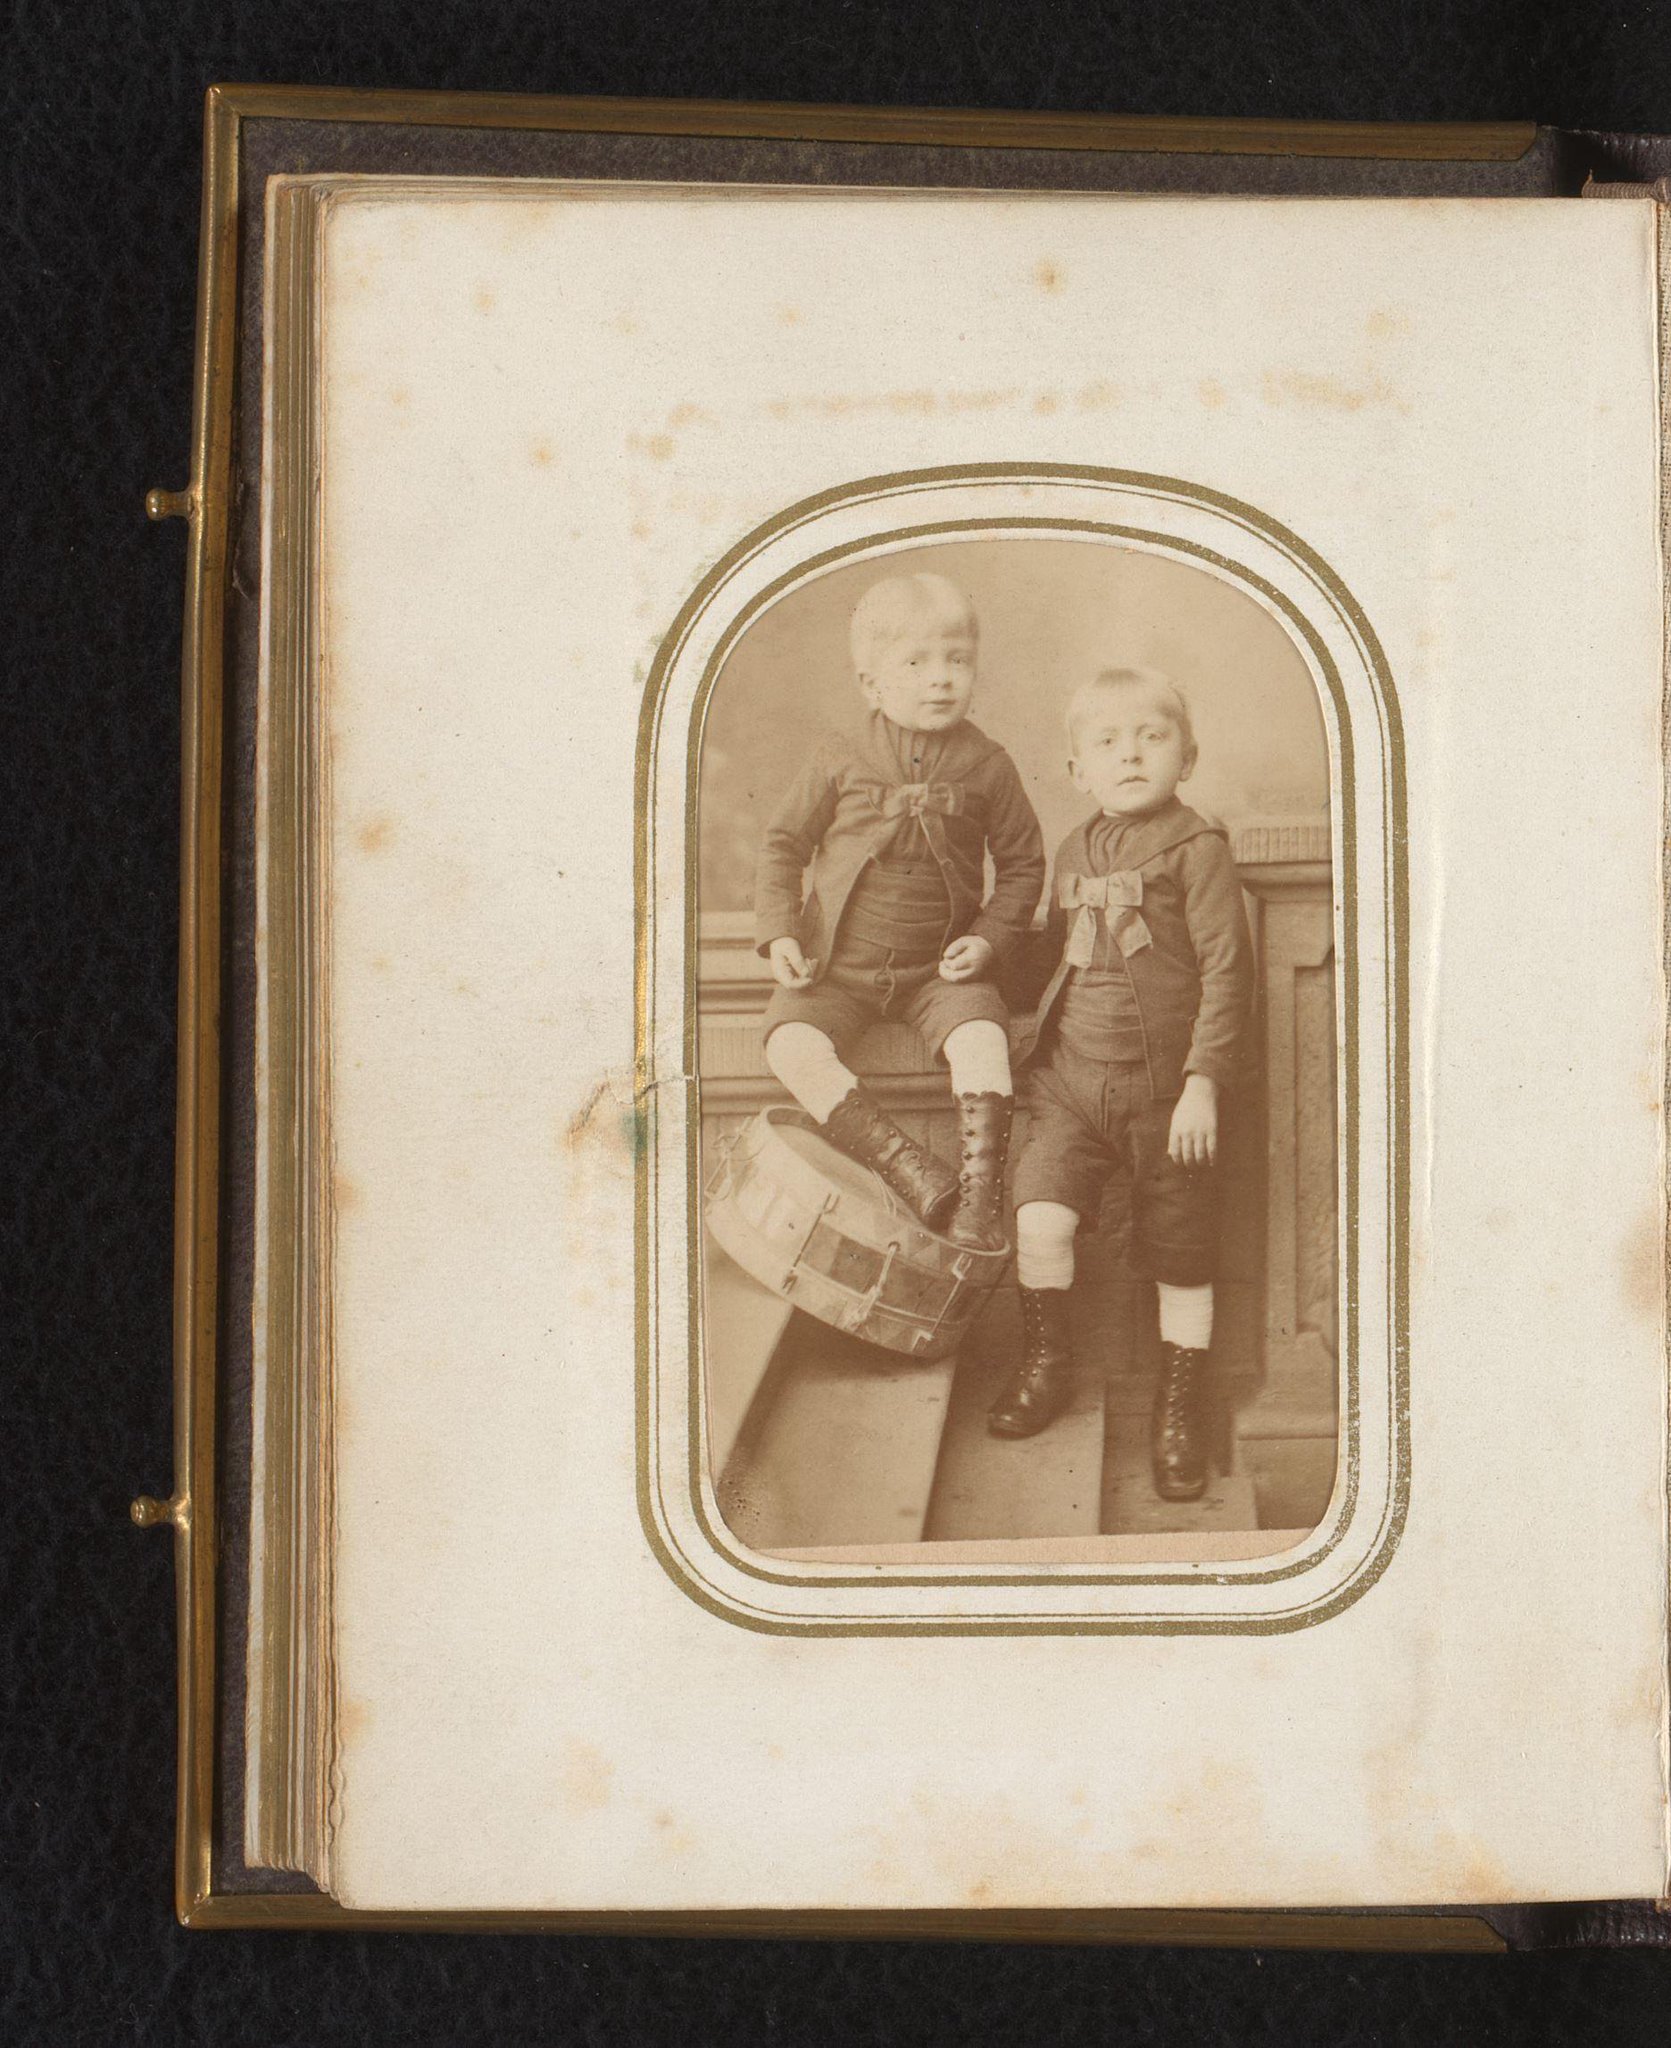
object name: carte de visite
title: Portret van twee jongens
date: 1881-1904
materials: cardboard, photographic support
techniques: albumen print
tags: boy (child between toddler and youth), historical persons, drum (musical instrument)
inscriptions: inscription: ‘Photographisch Atelier/ van/ Brainich & Leusink/ Menthensteeg No. 7/ Arnhem’